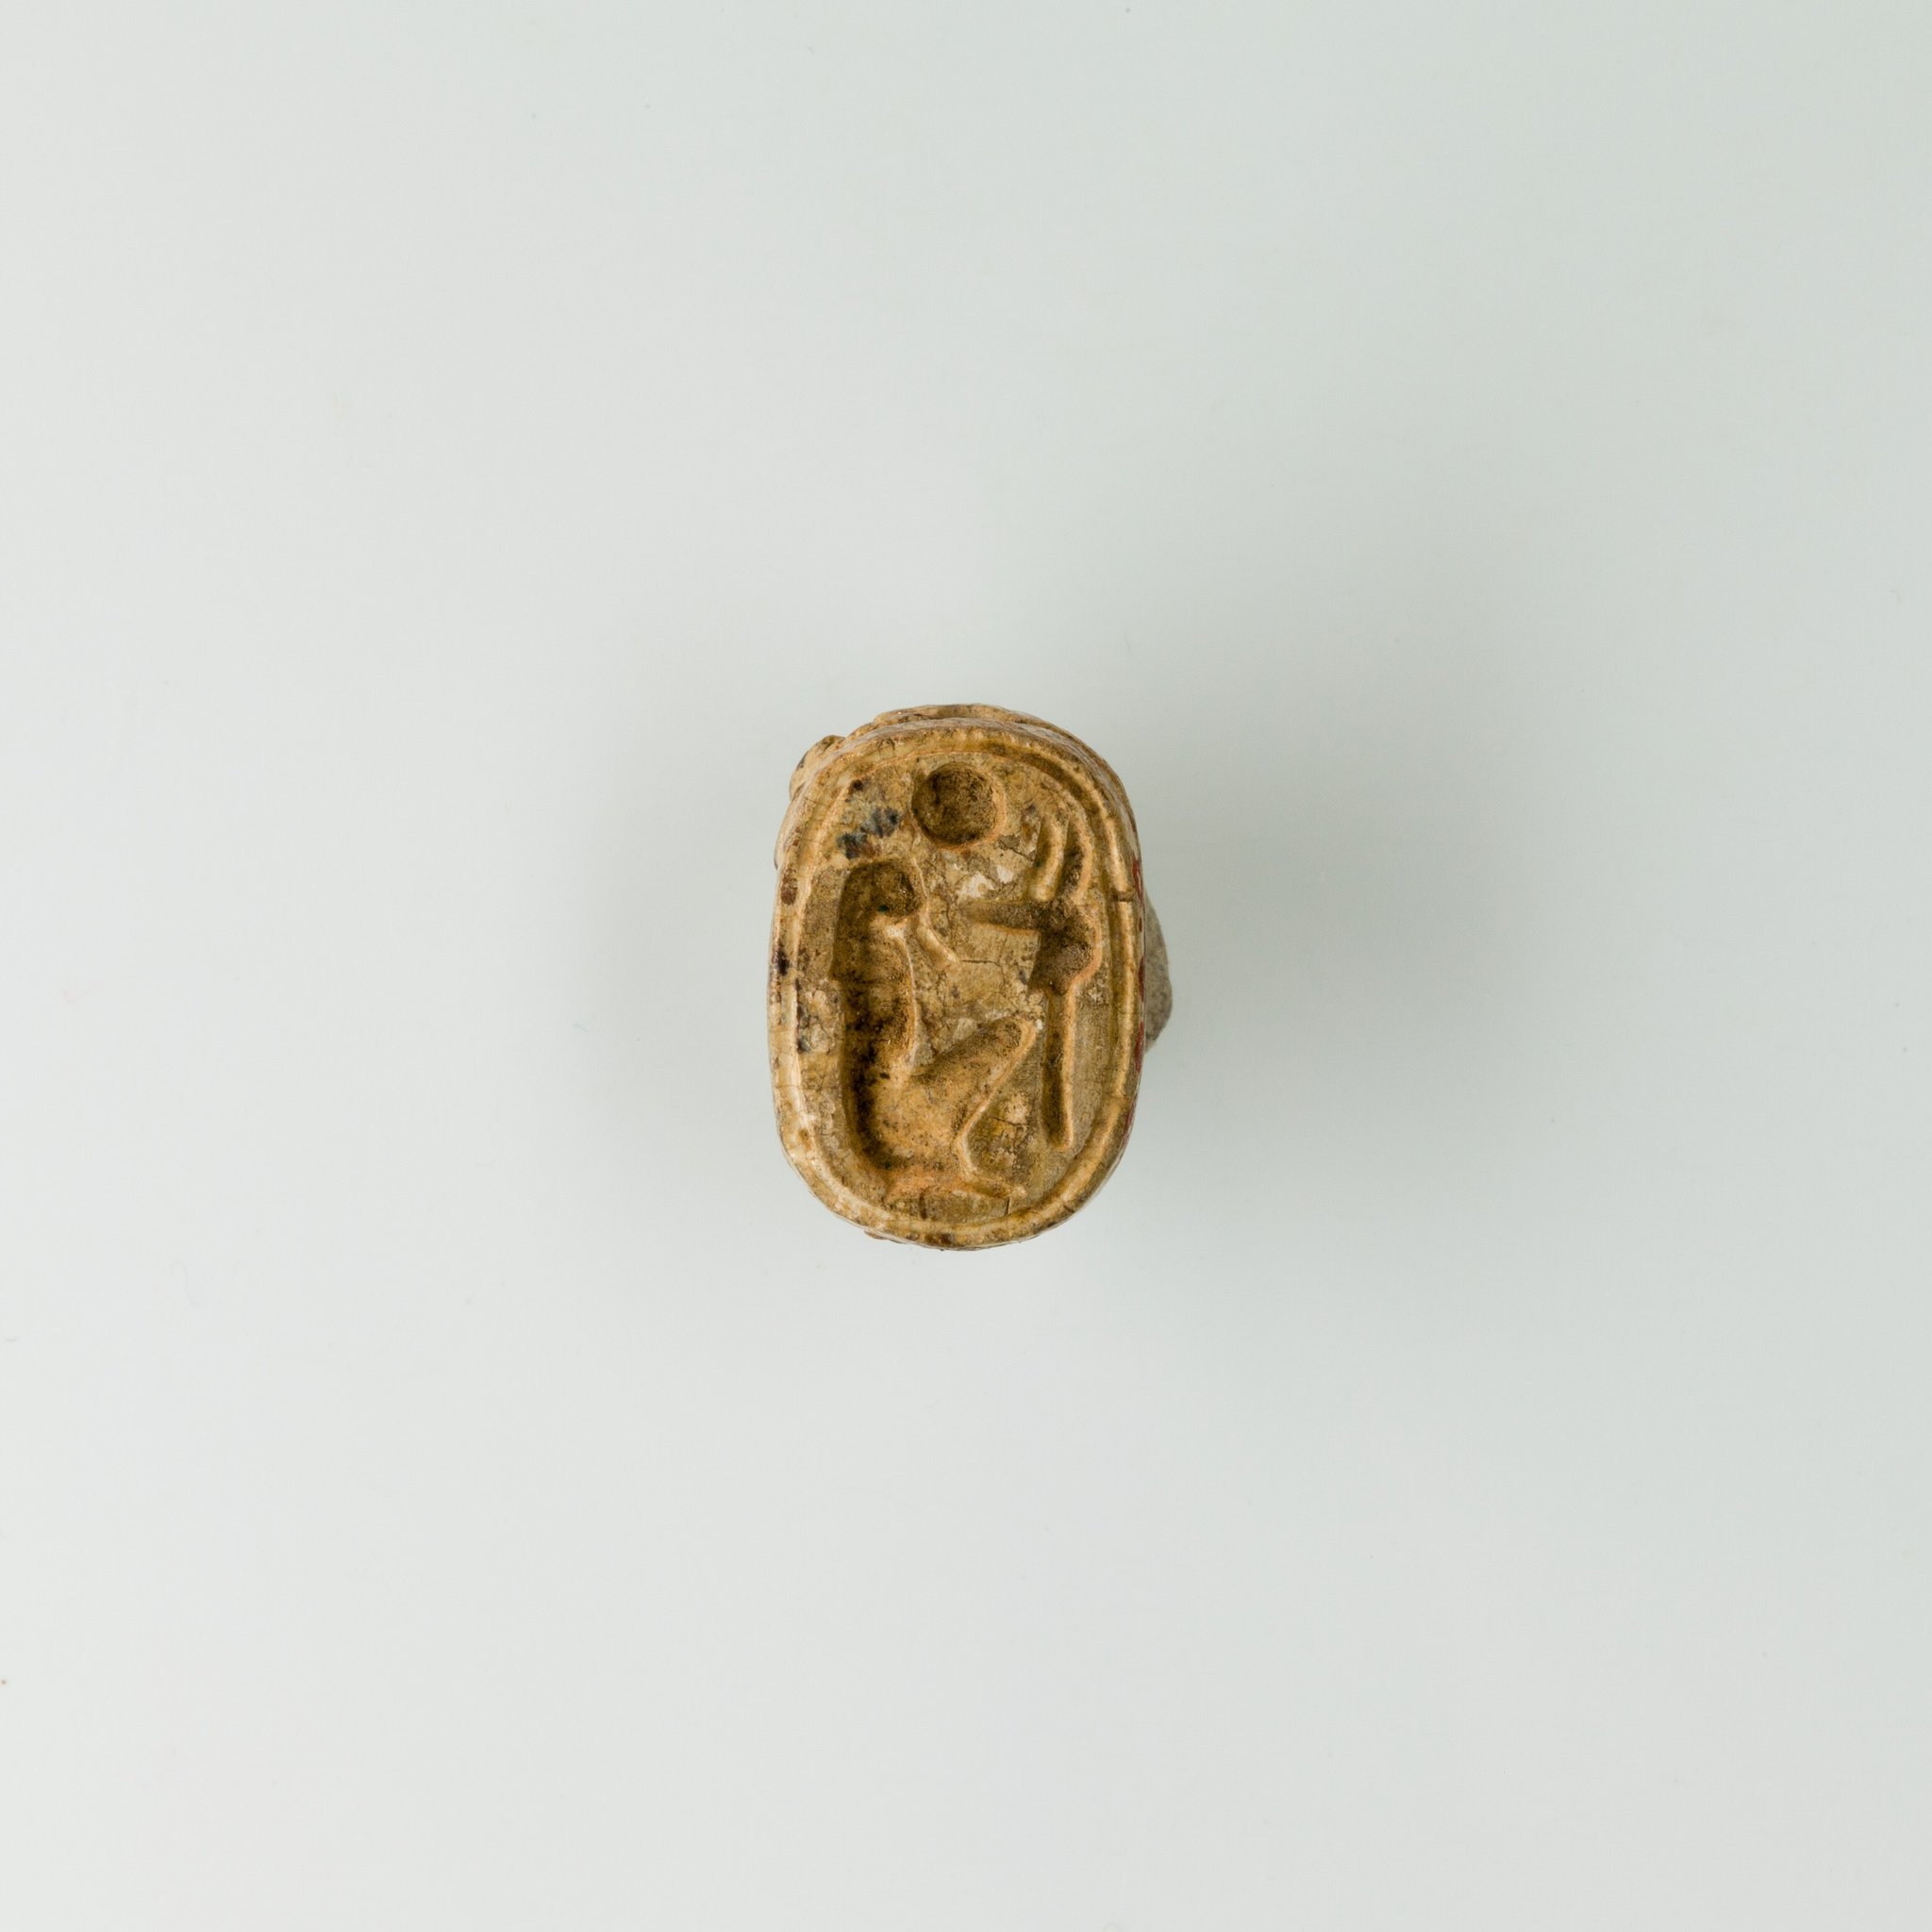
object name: seal, lion, ramesses ii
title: Lion seal of Ramesses II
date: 1295-1070 BCE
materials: stone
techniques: glazing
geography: egypt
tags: lions